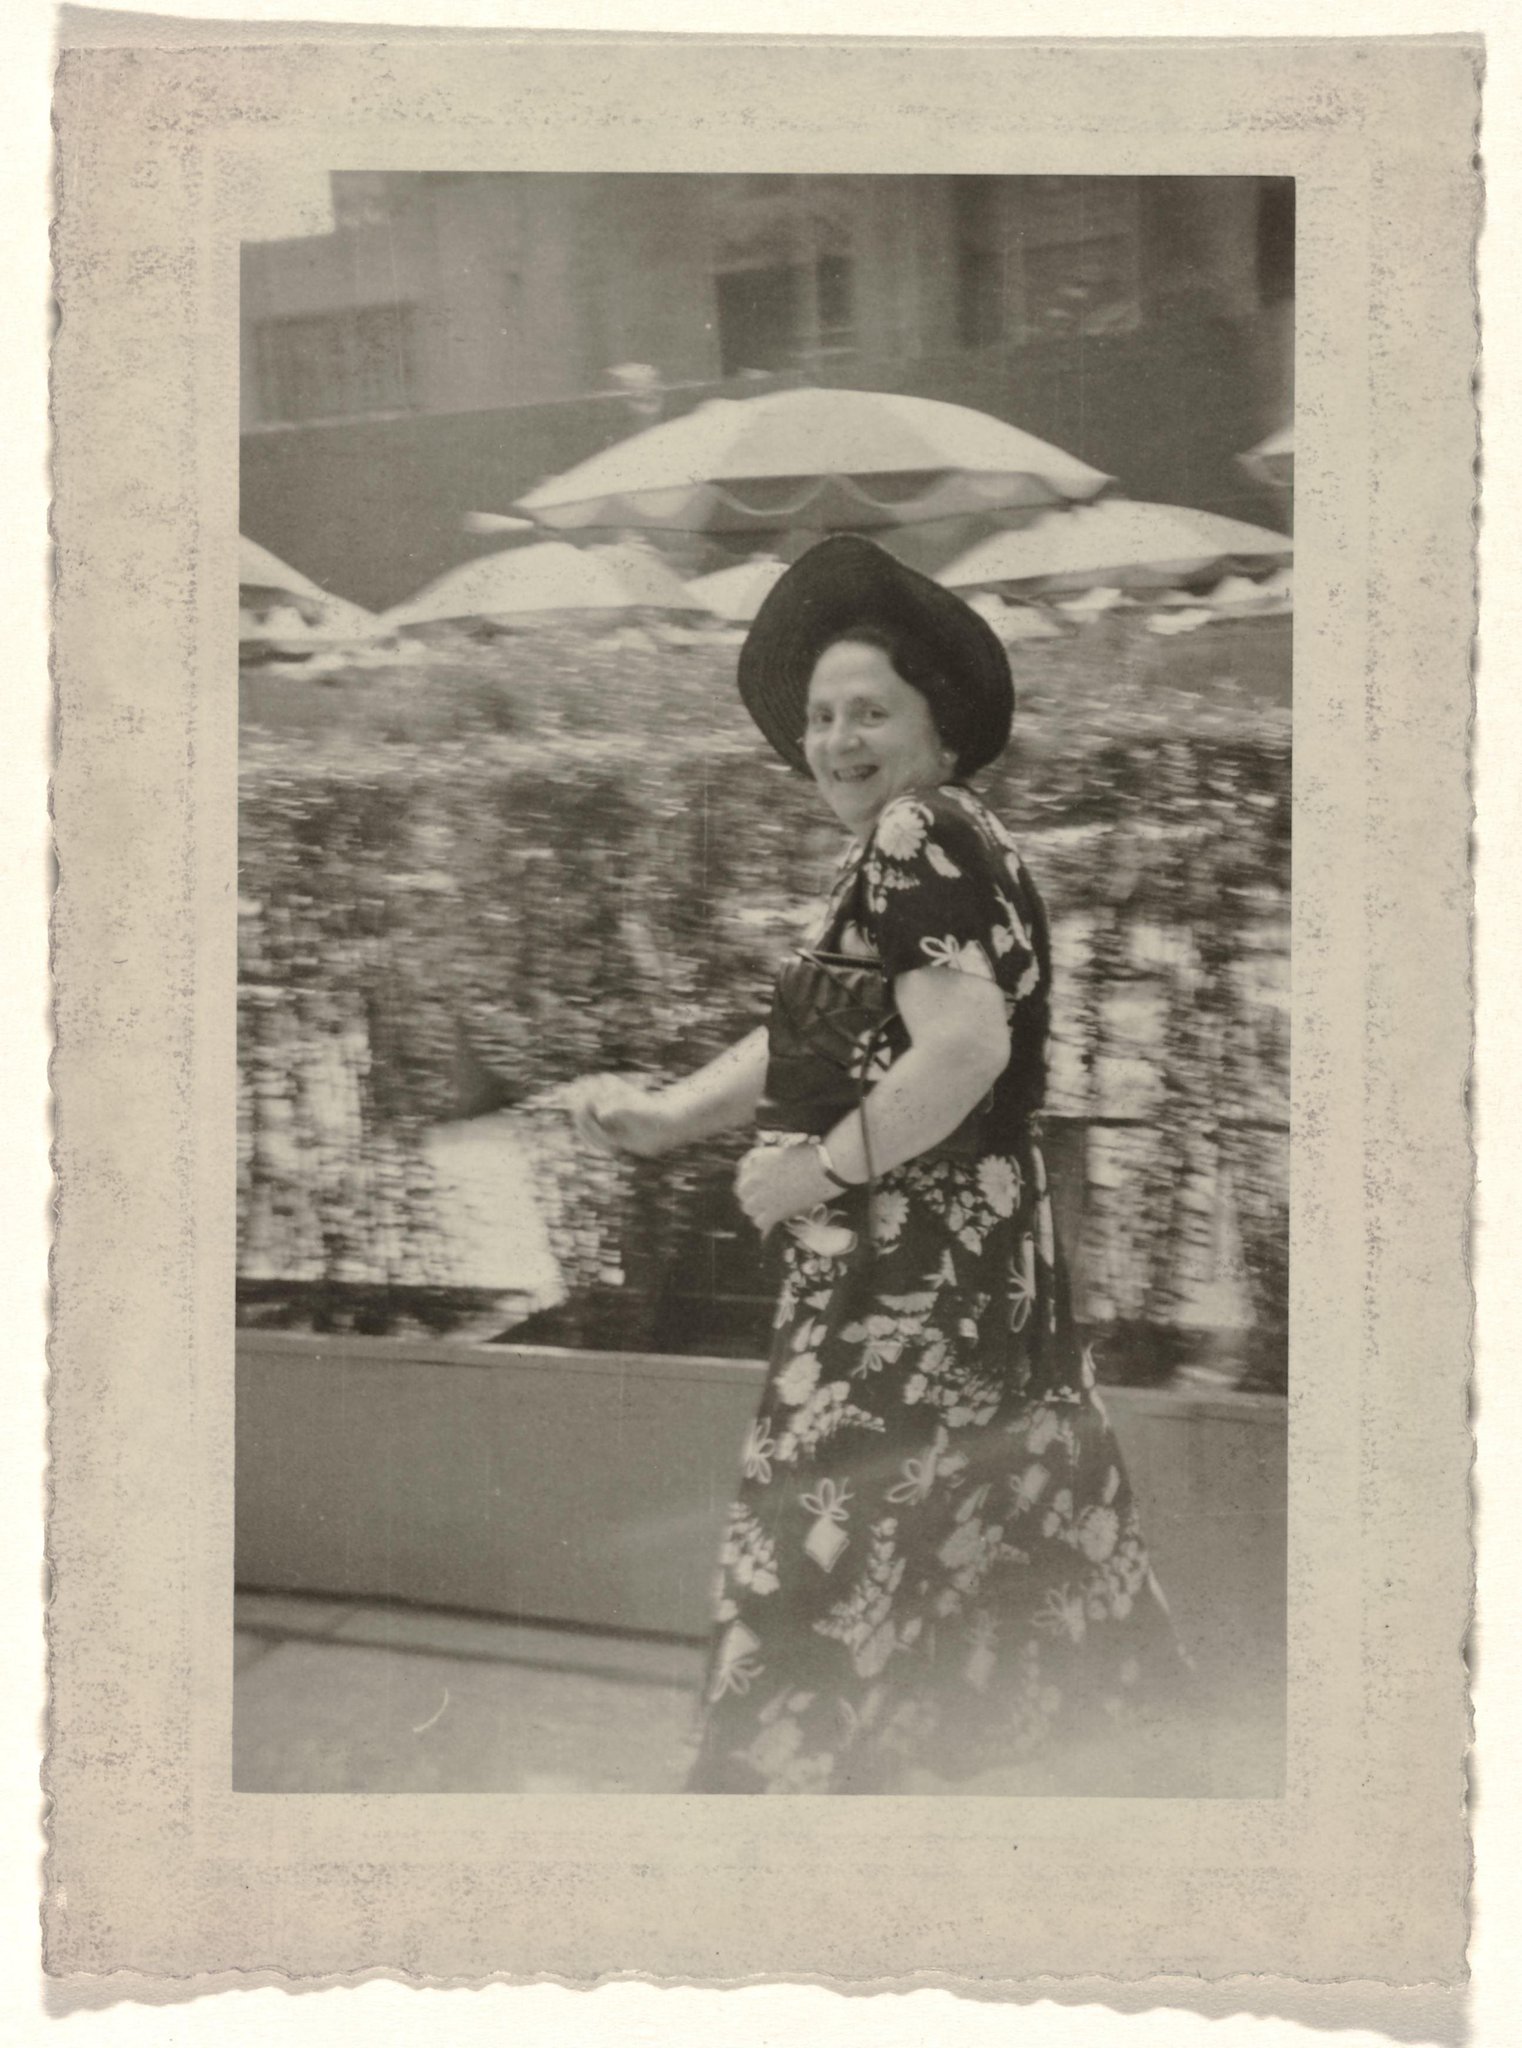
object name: photograph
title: Tante Rosel in jurk met versierd motief en hoed op haar hoofd, lopende voor een struikenhaag met parasols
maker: Anonymous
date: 1907-1950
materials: photographic support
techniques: gelatin silver print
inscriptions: inscription: ‘meinen geliebten Isabel Rosel tante. July 1950’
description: Tante Rosel in jurk met versierd motief en hoed op haar hoofd, lopende voor een struikenhaag met parasols en een gebouw op de achtergrond